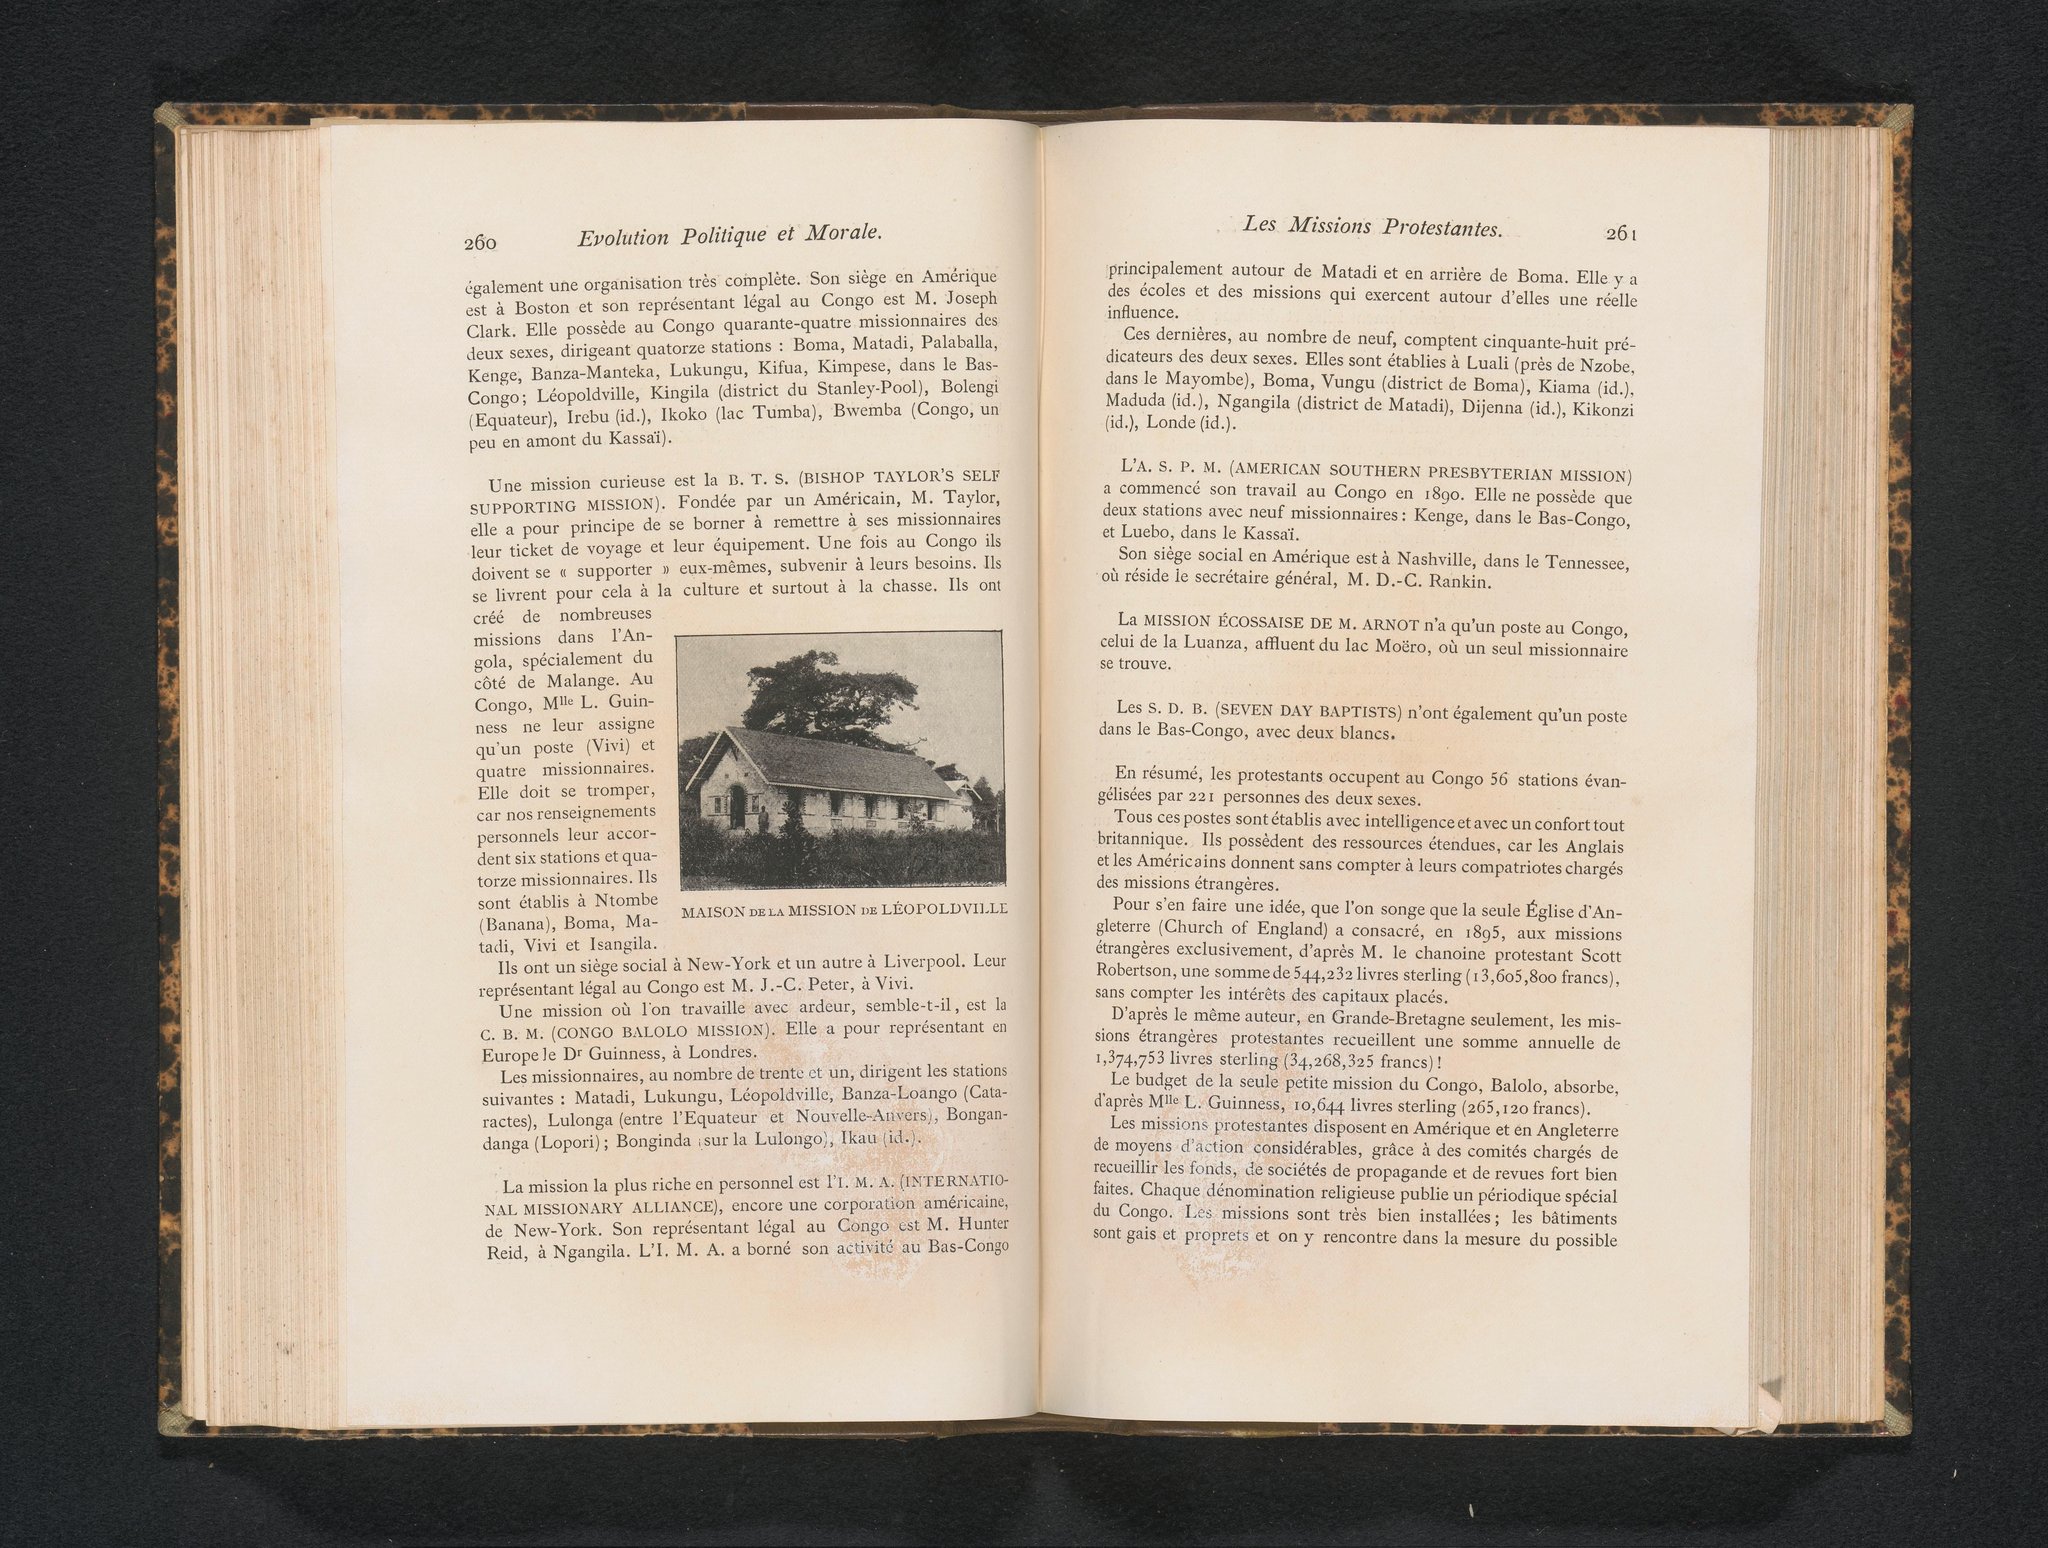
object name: photomechanical print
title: Maison de la mission de Léopoldville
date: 1887-1892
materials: paper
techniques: autotype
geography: congo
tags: façade (of house or building)